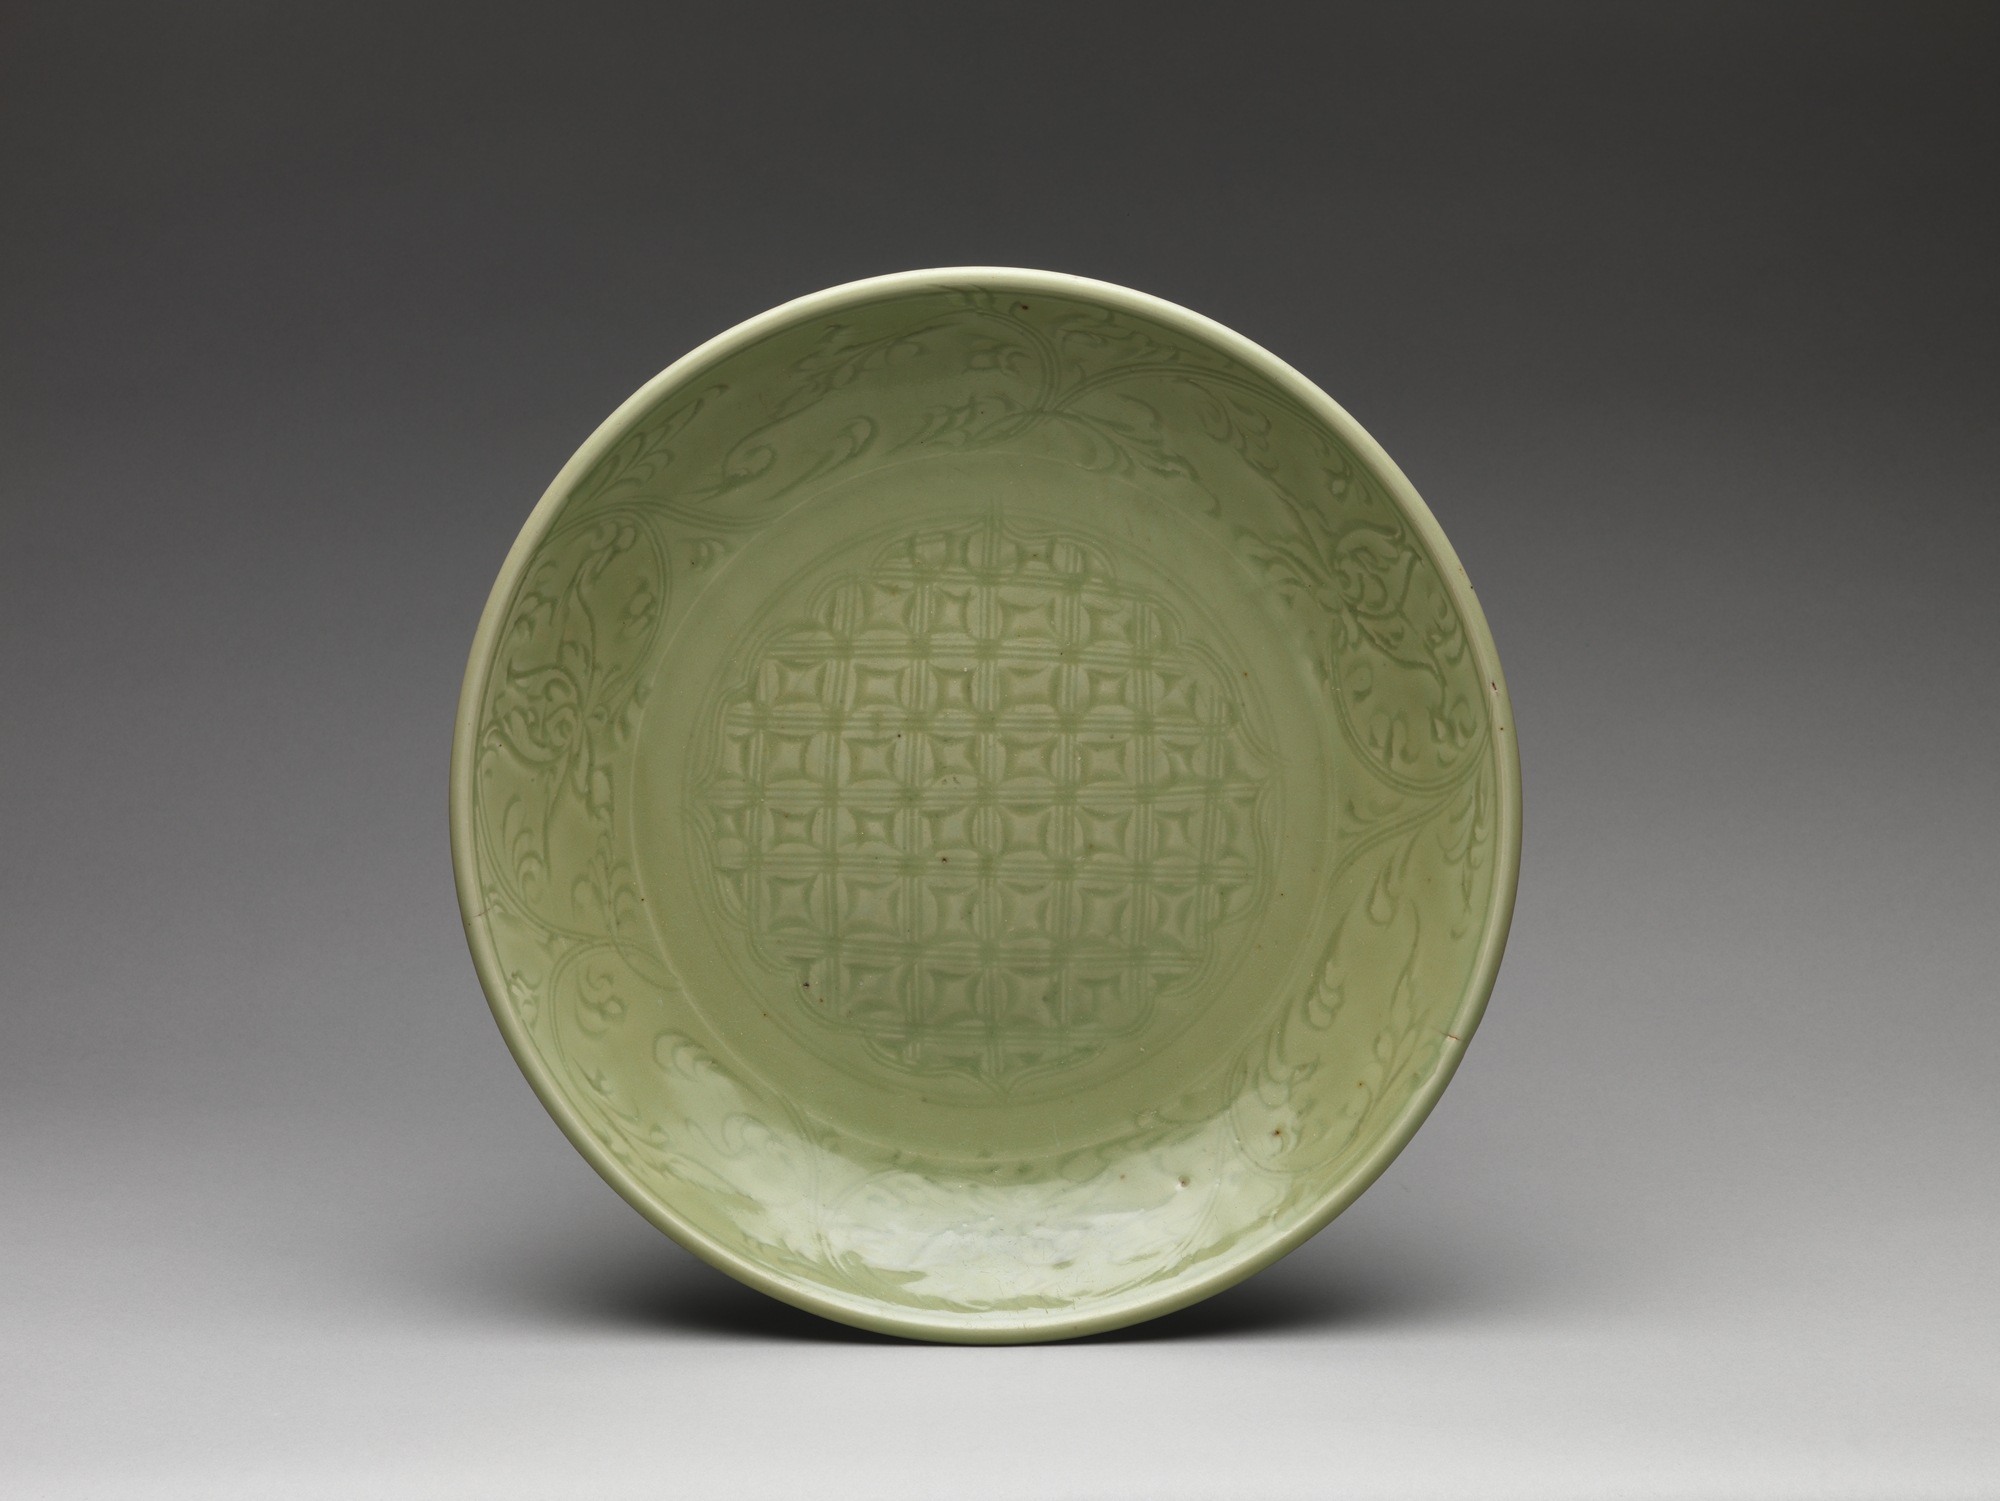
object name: dish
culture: chinese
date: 1367-1433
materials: ceramic glaze, glaze, porcelain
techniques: incising